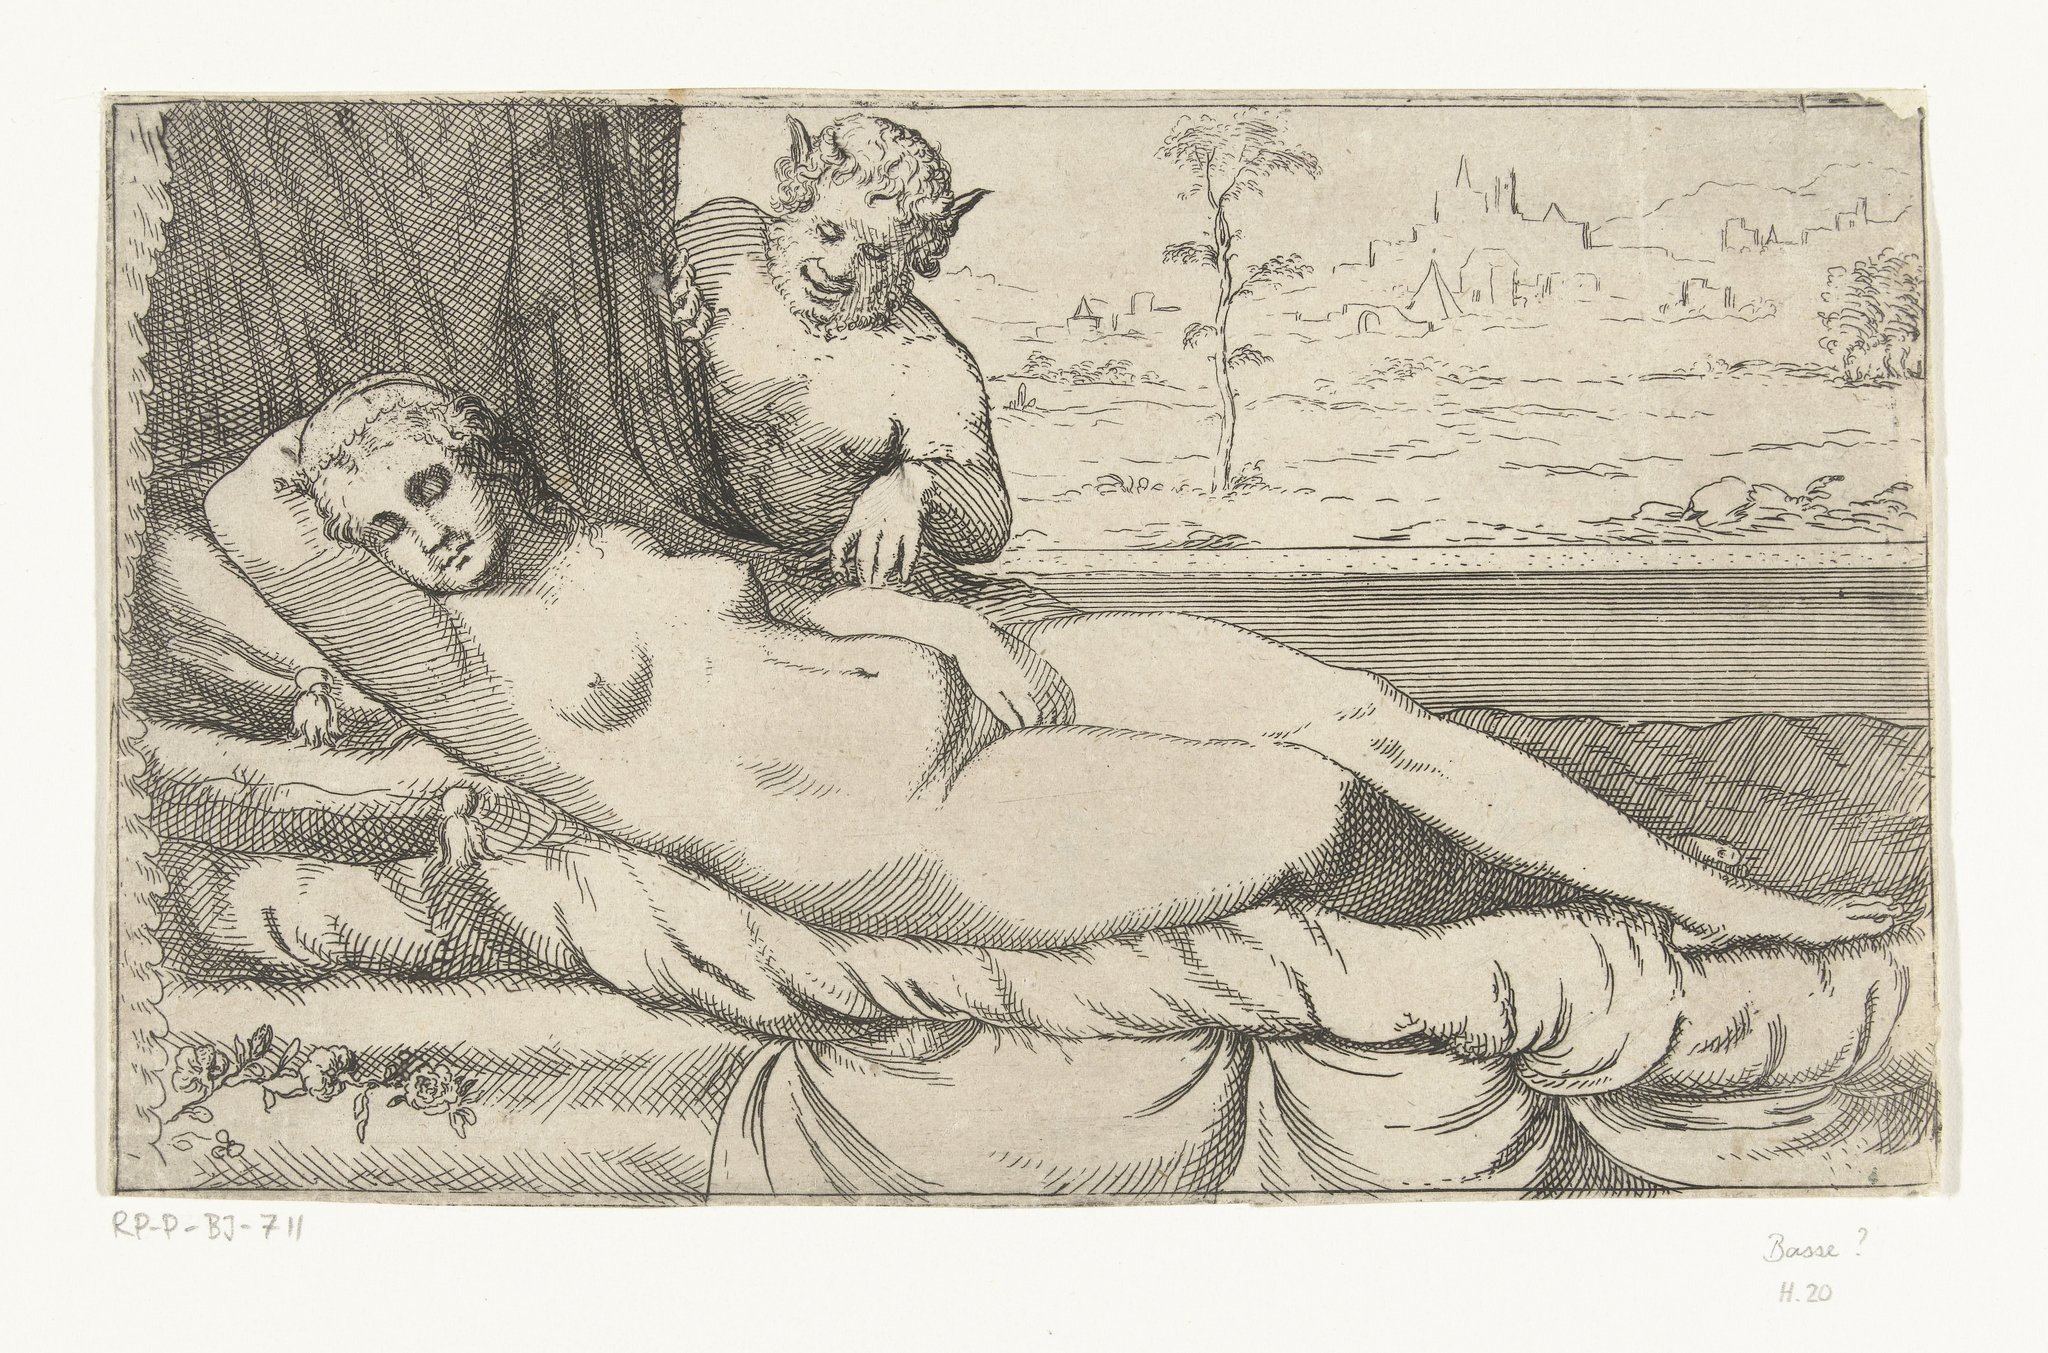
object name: print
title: Een slapende nimf van voren gezien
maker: willem basse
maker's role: draughtsman, print maker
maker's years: 1613-1672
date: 1633-1672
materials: paper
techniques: etching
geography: amsterdam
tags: satyr(s) pursuing nymph(s), sleeping; unconsciousness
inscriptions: collector's mark: Lugt 240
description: Een slapende nimf van voren gezien, vanachter een gordijn kijkt een sater naar haar. Op de achtergrond is een landschap met een stadsgezicht.